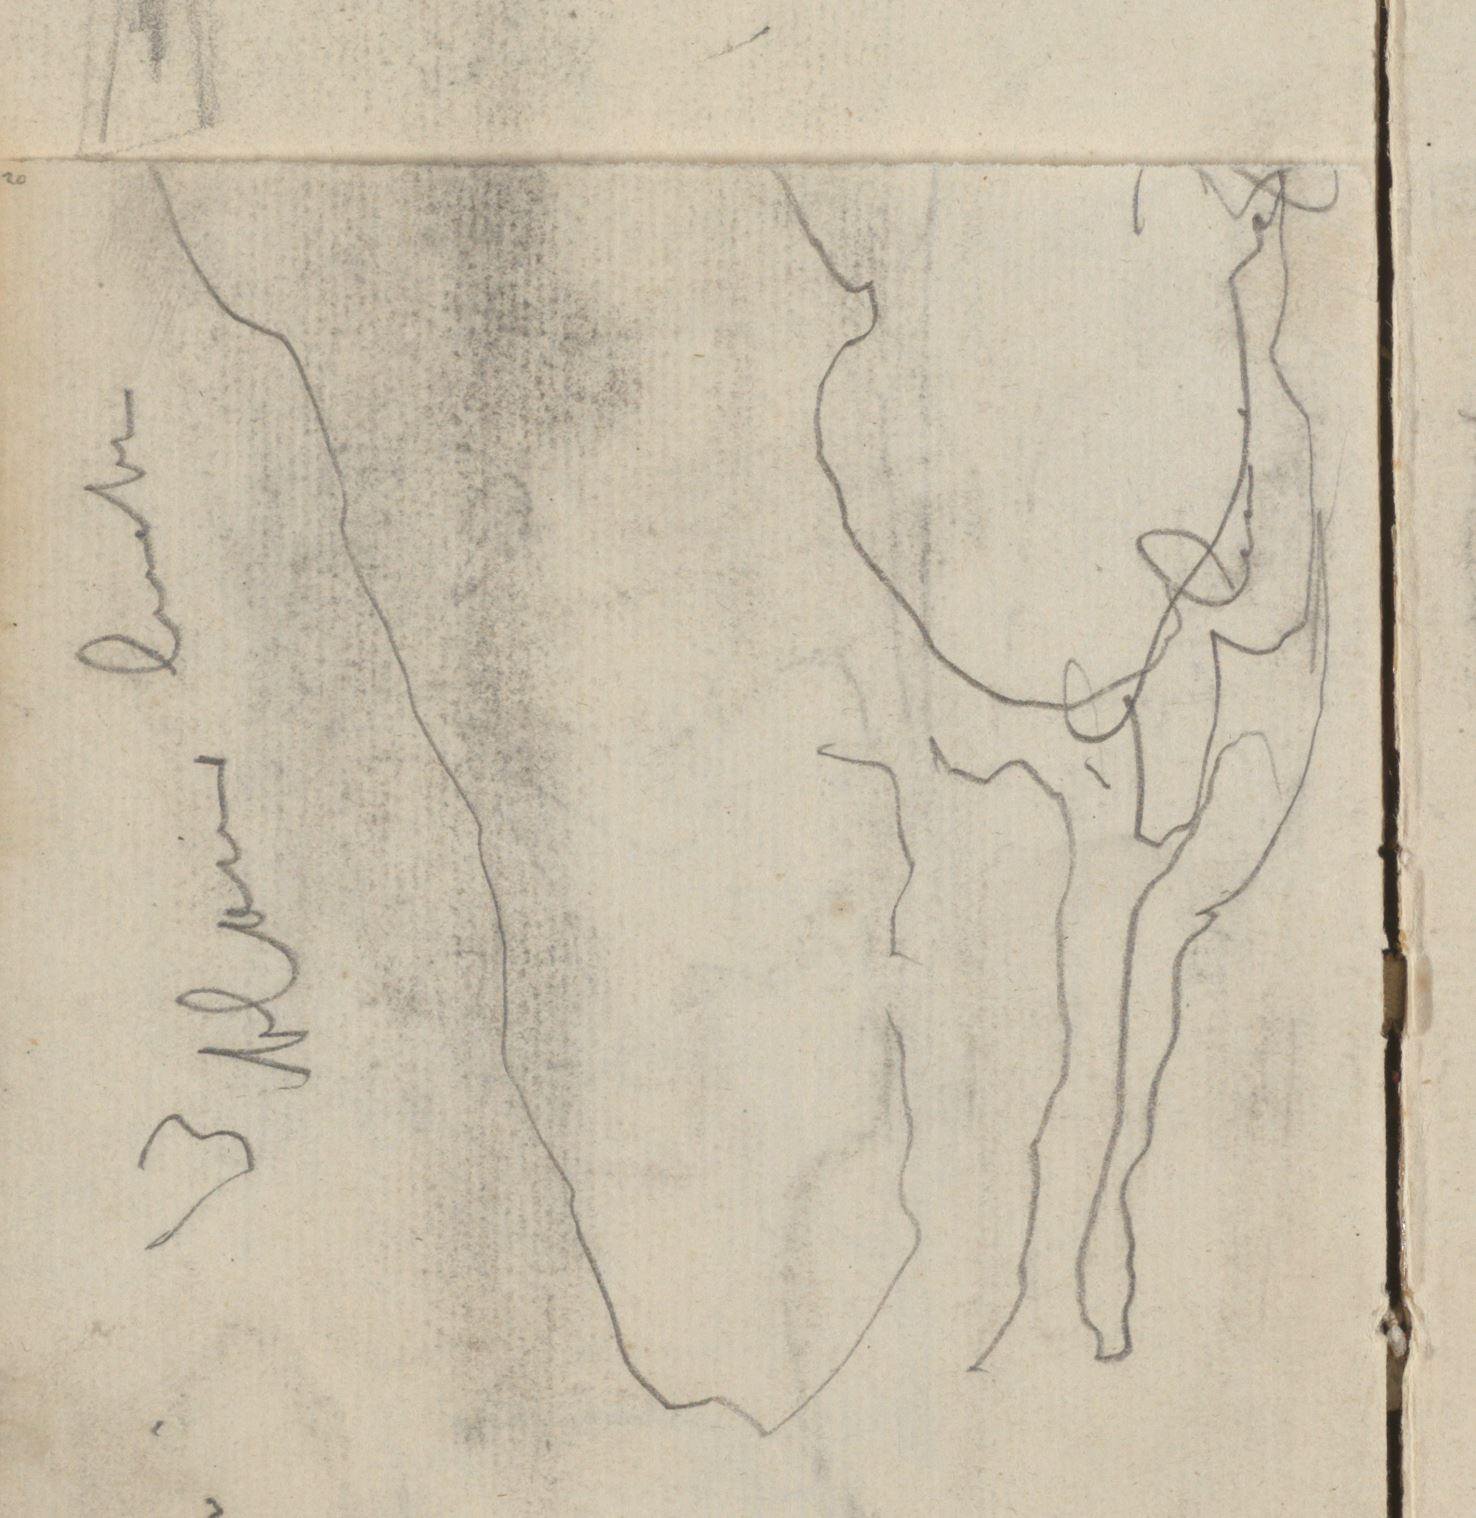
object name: sketchbook leaf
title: Wolkenlucht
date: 1881-1883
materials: paper, pencil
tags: clouds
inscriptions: kleurnotitie, handgeschreven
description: Pagina 20 uit een schetsboek met 29 bladen.